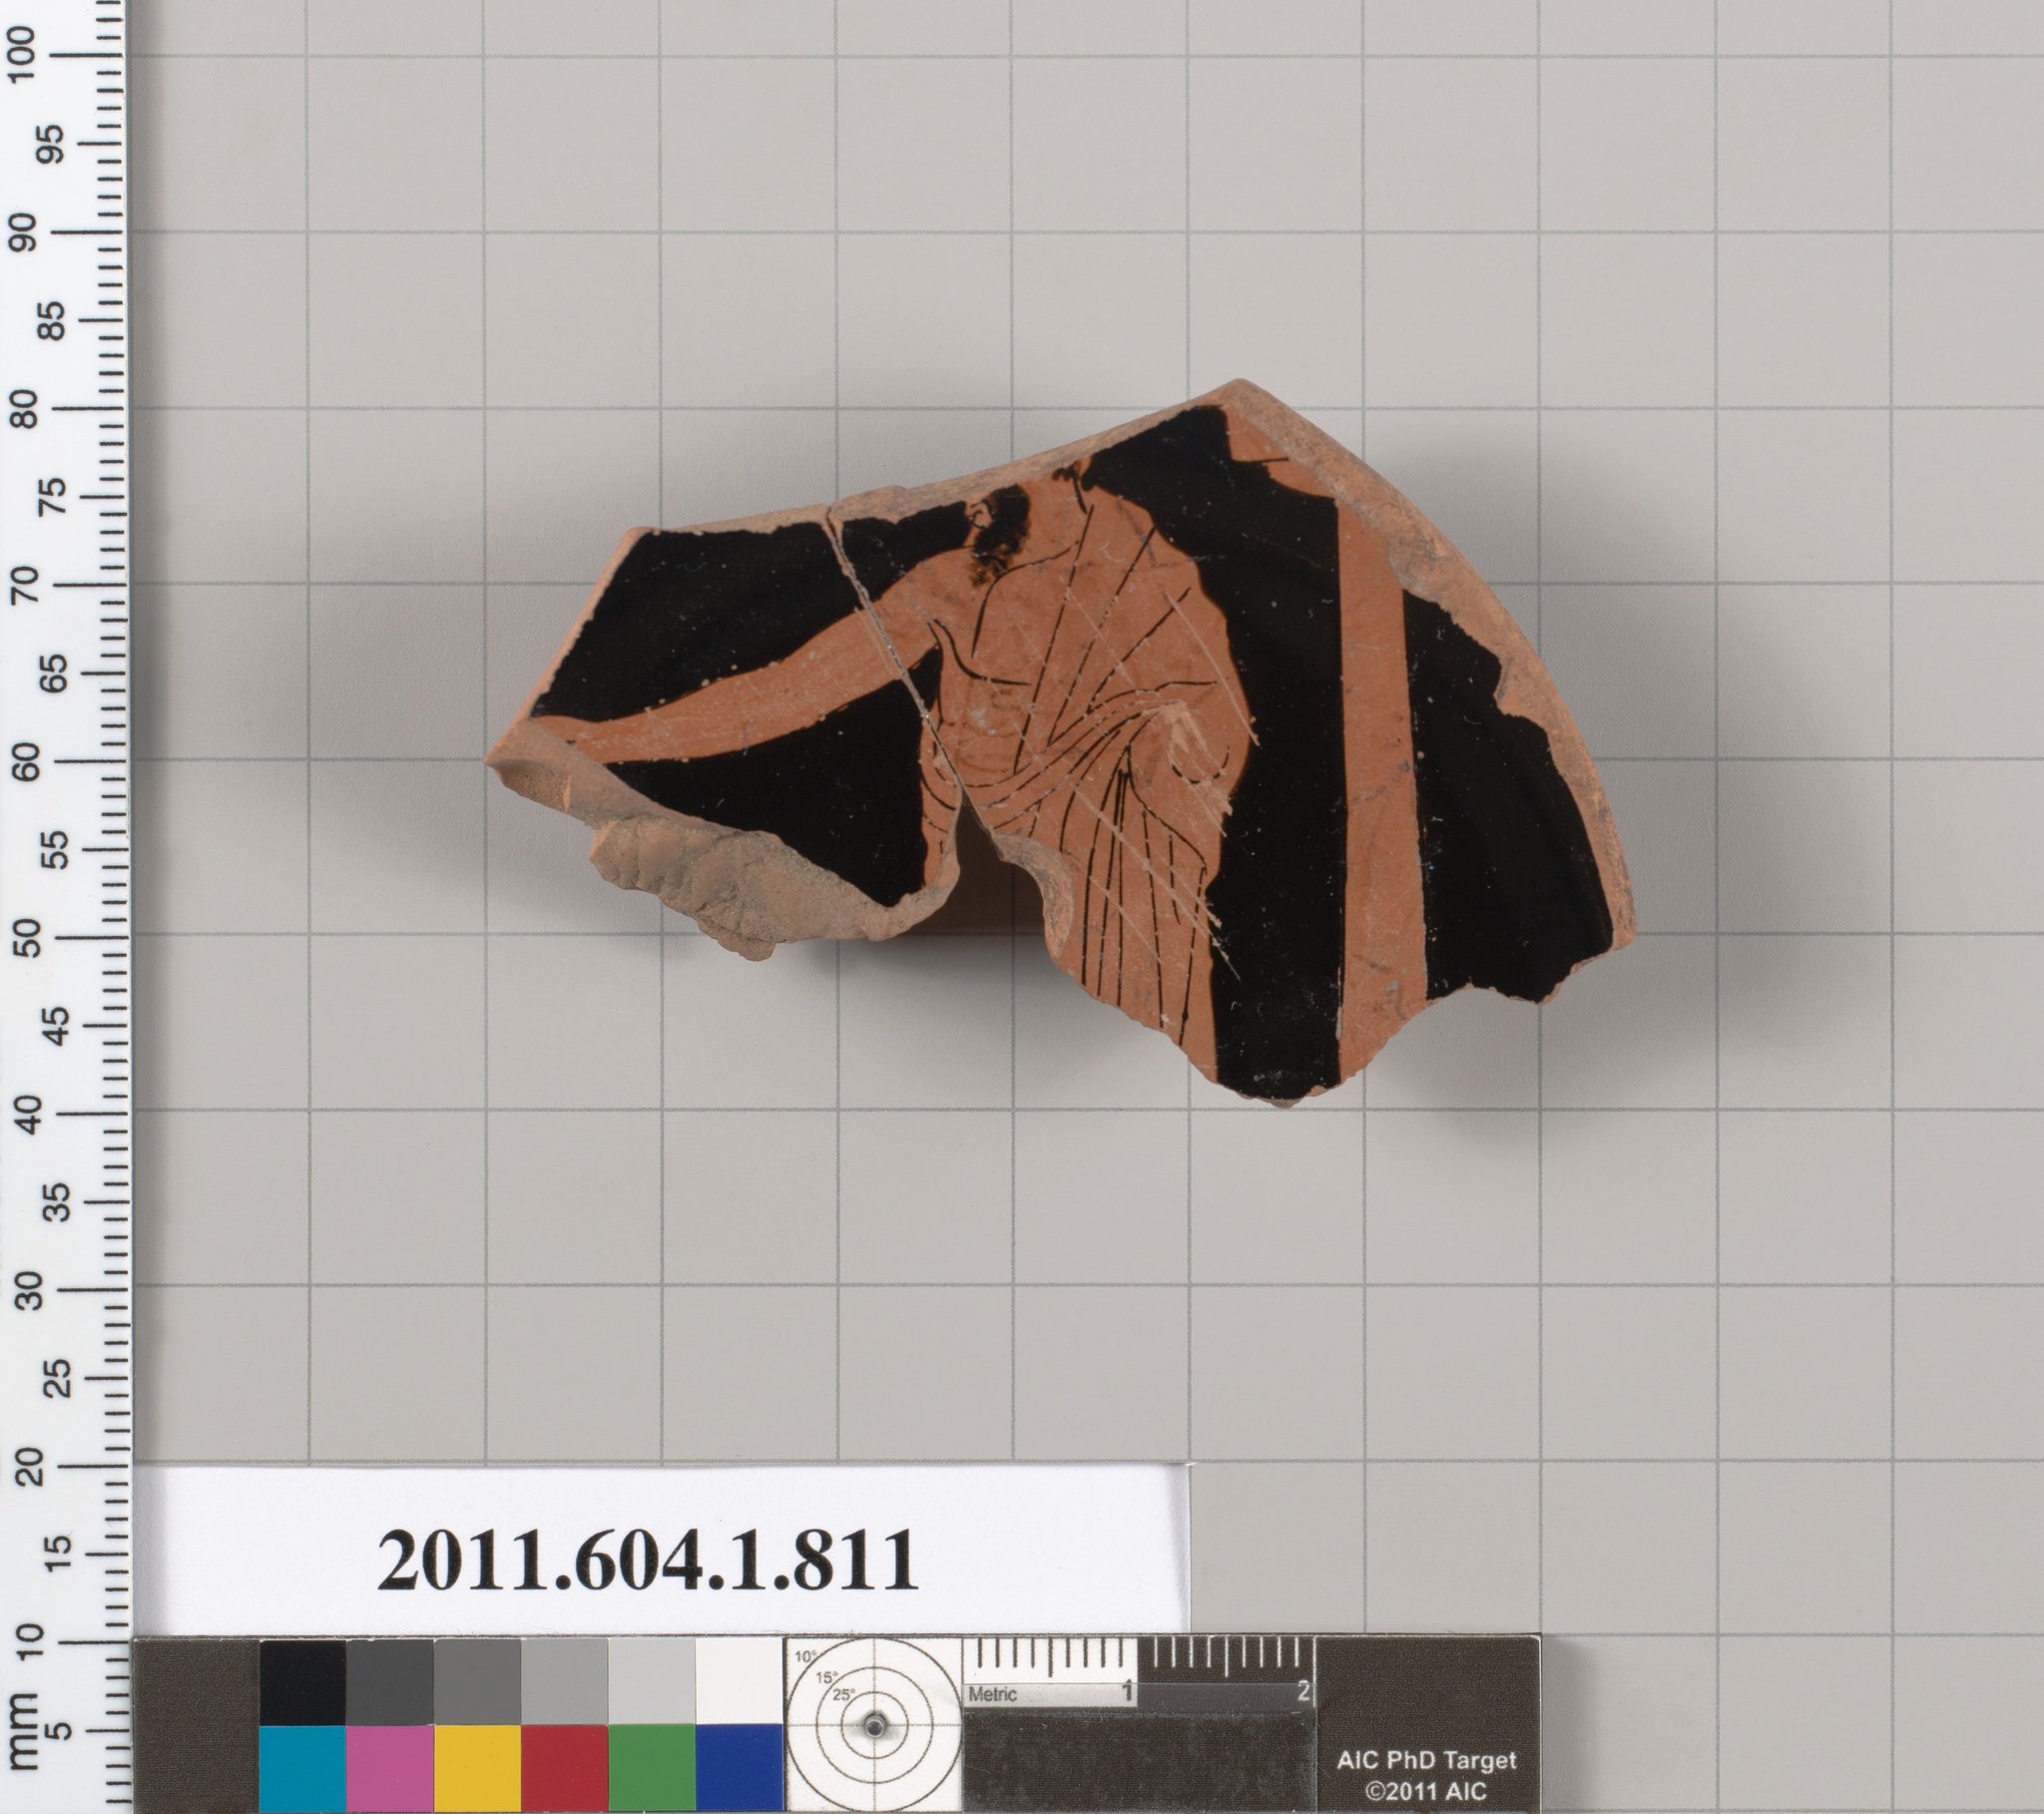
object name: kylix fragment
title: Terracotta fragment of a kylix (drinking cup)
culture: greek, attic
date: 475-451 BCE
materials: terracotta